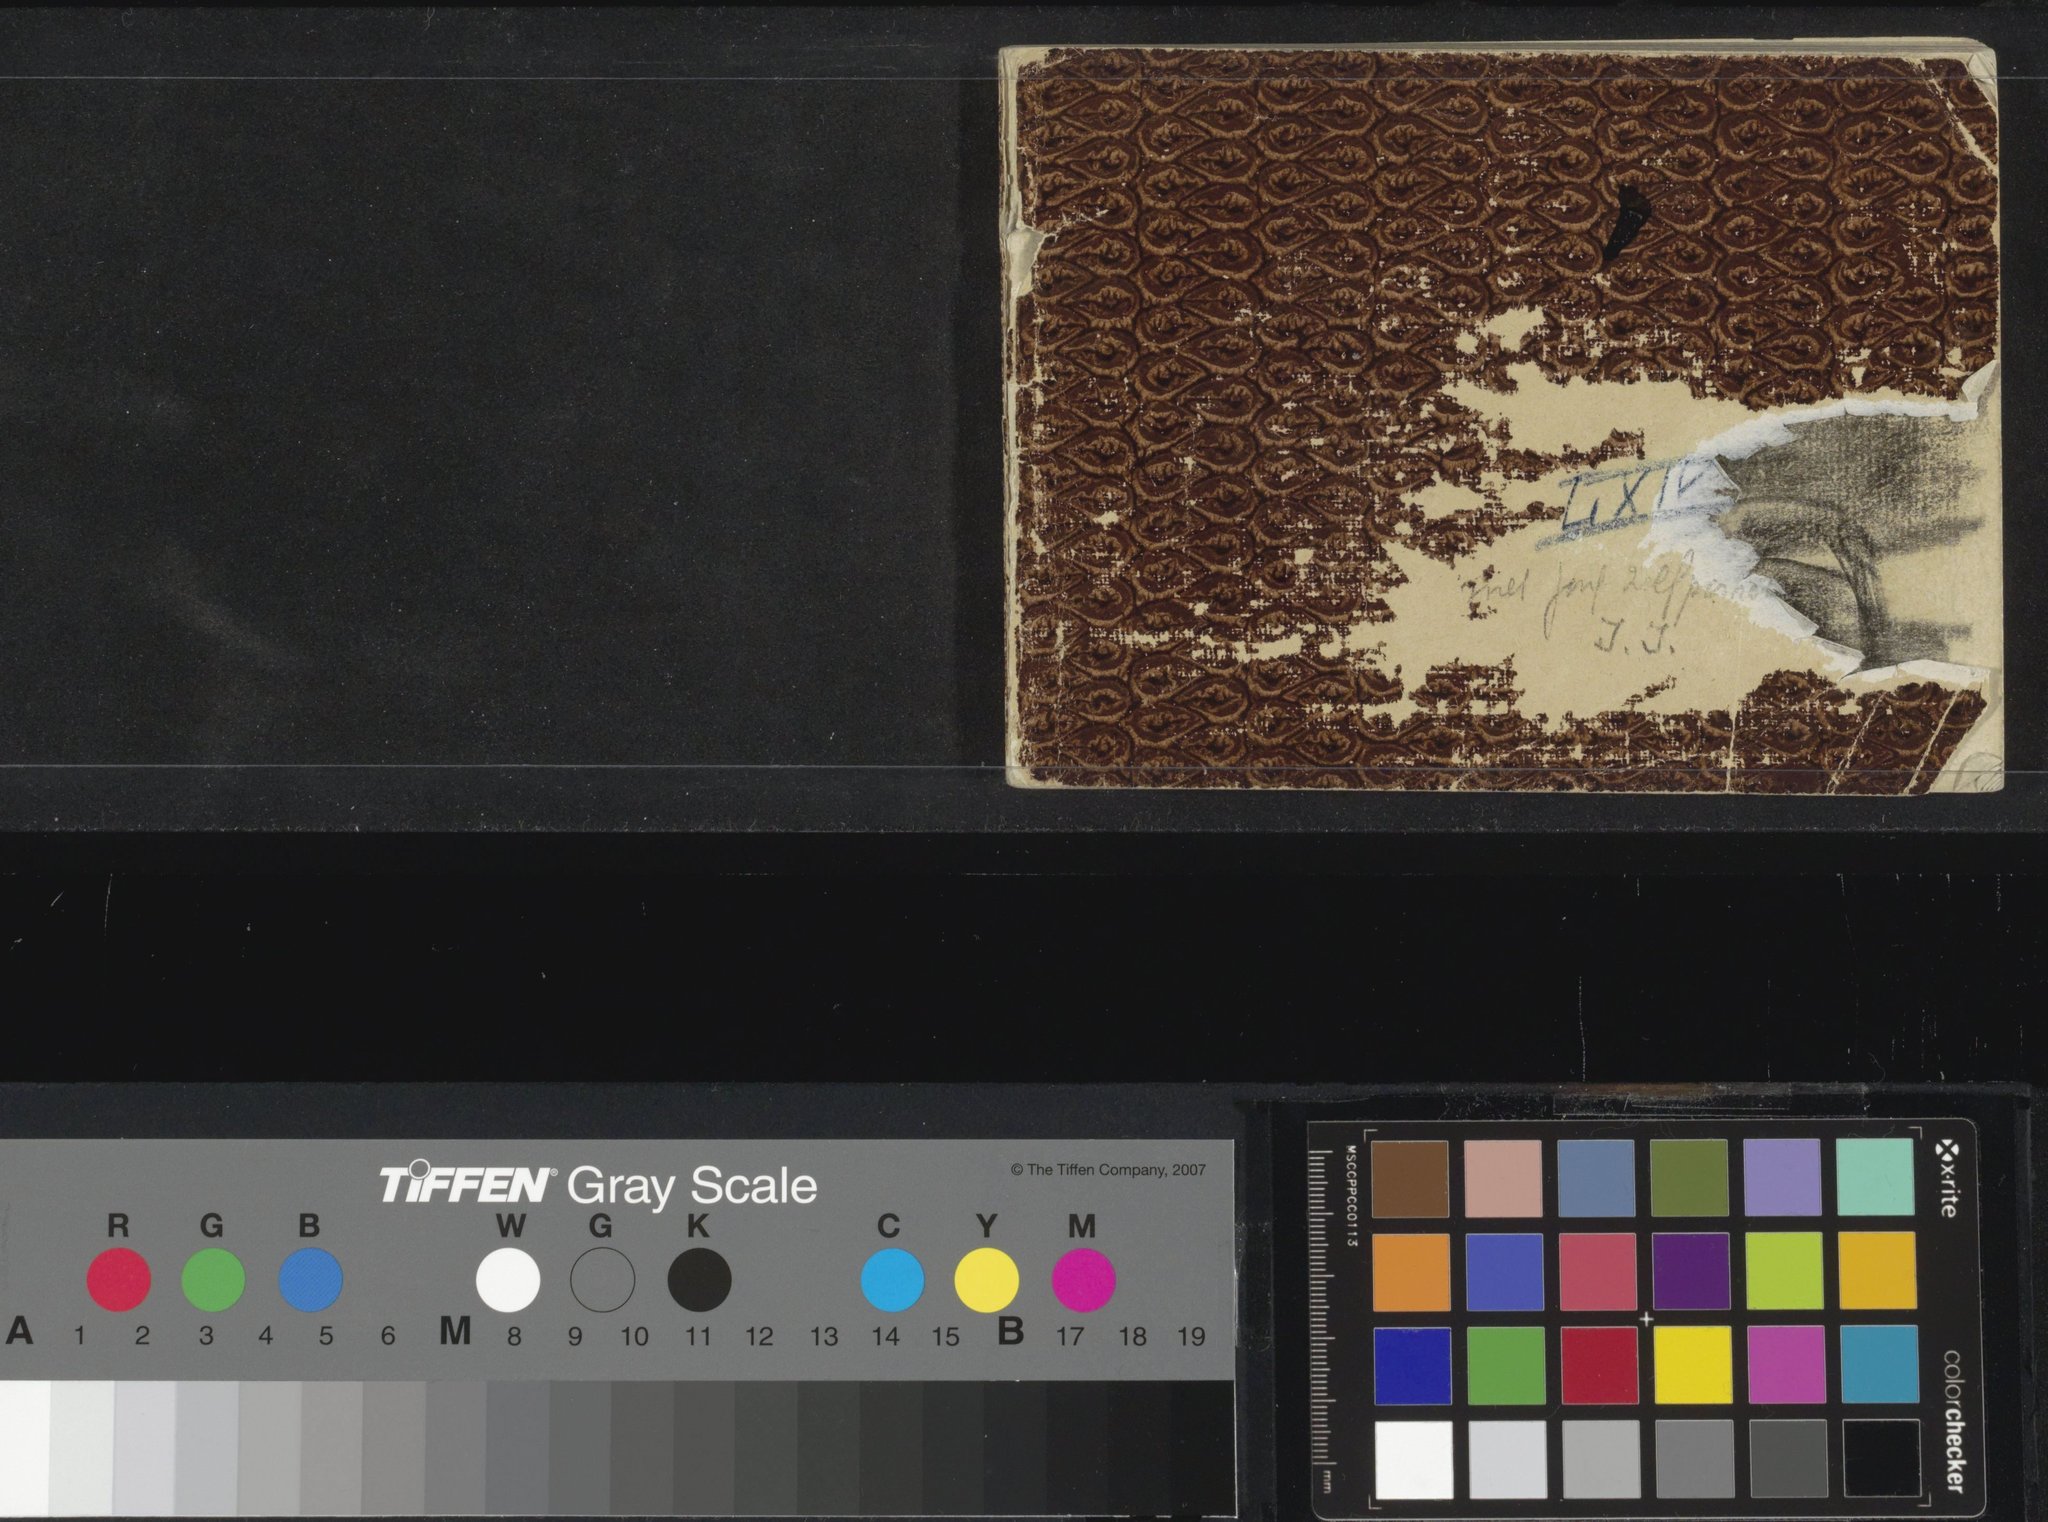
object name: sketchbook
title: Schetsboek LXIV met 29 bladen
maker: isaac israels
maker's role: draughtsman, painter, print maker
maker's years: 1865-1934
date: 1886-1934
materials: chalk, paper, pencil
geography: amsterdam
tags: amsterdam, the hague, painter, print maker, draughtsman, isaac israels, portrait, self-portrait of painter, portrait, self-portrait of artist, street (+ city(-scape) with figures, staffage)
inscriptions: collector's mark: Lugt 2228, annotation: ‘met jong zelfportret / I.I.’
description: Schetsboek nr. LXIV bestaande uit 29 bladen met straatgezichten, figuurstudies en een zelfportret.